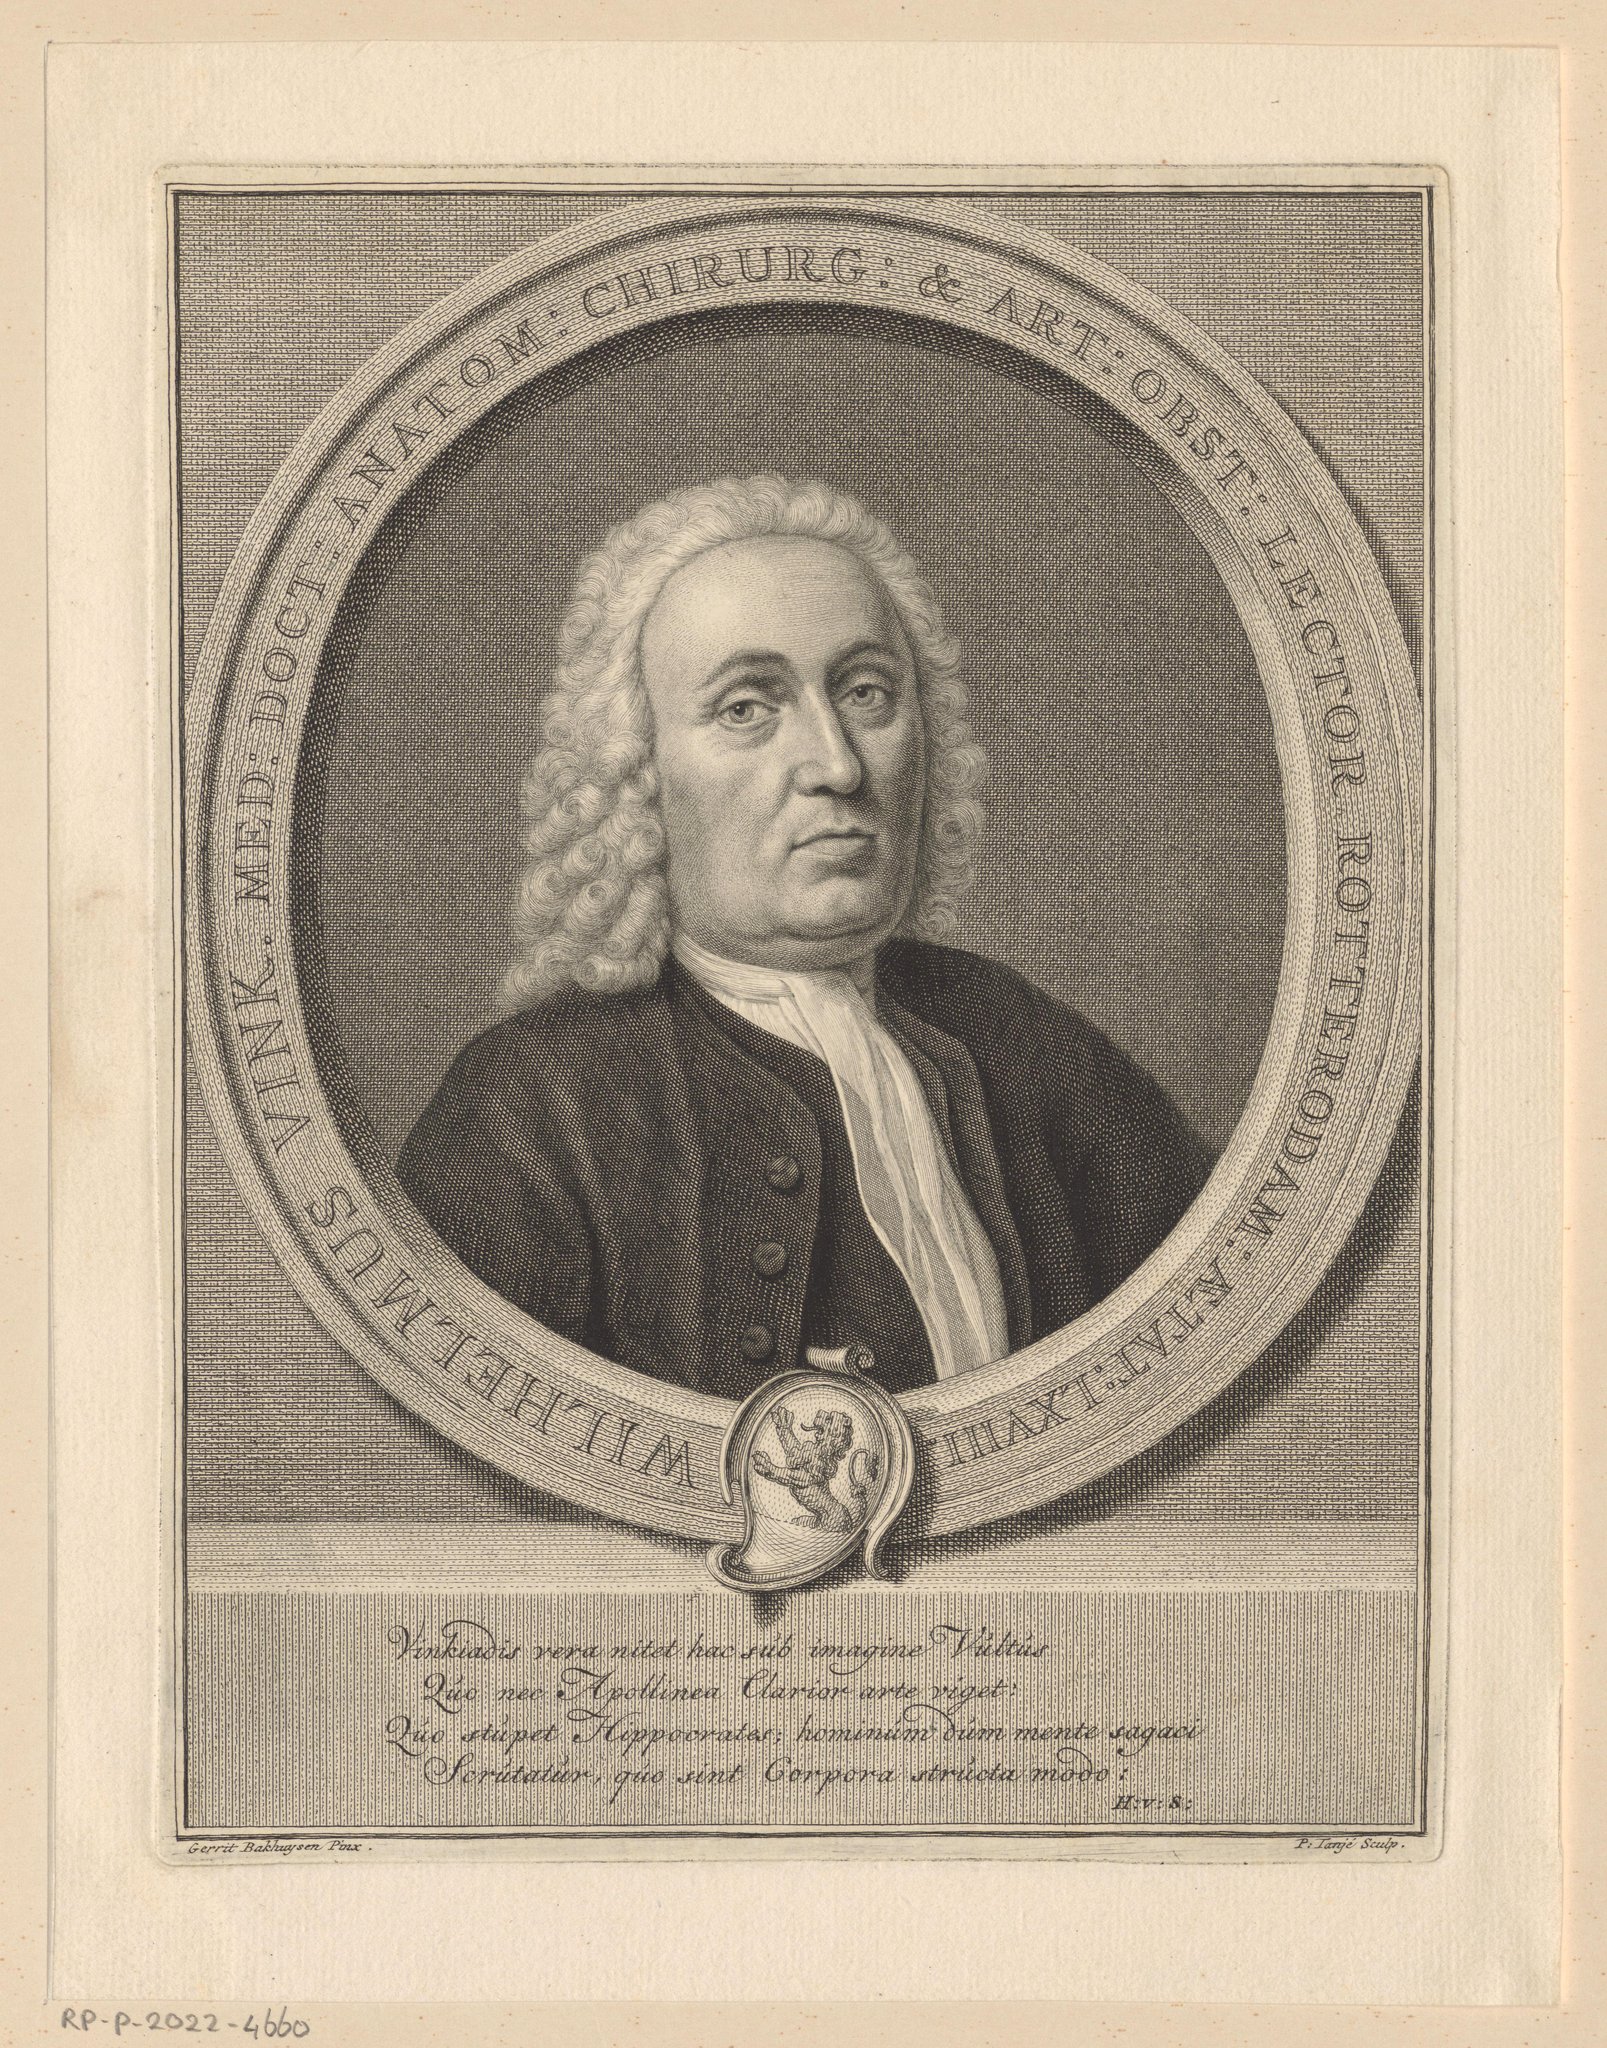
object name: print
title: Portret van Willem Vink op 68-jarige leeftijd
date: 1731-1761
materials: paper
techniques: engraving, etching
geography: low countries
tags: historical persons, physician, doctor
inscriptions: monogram: ‘H:V:S.’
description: Met vierregelig onderschrift in het Latijn.